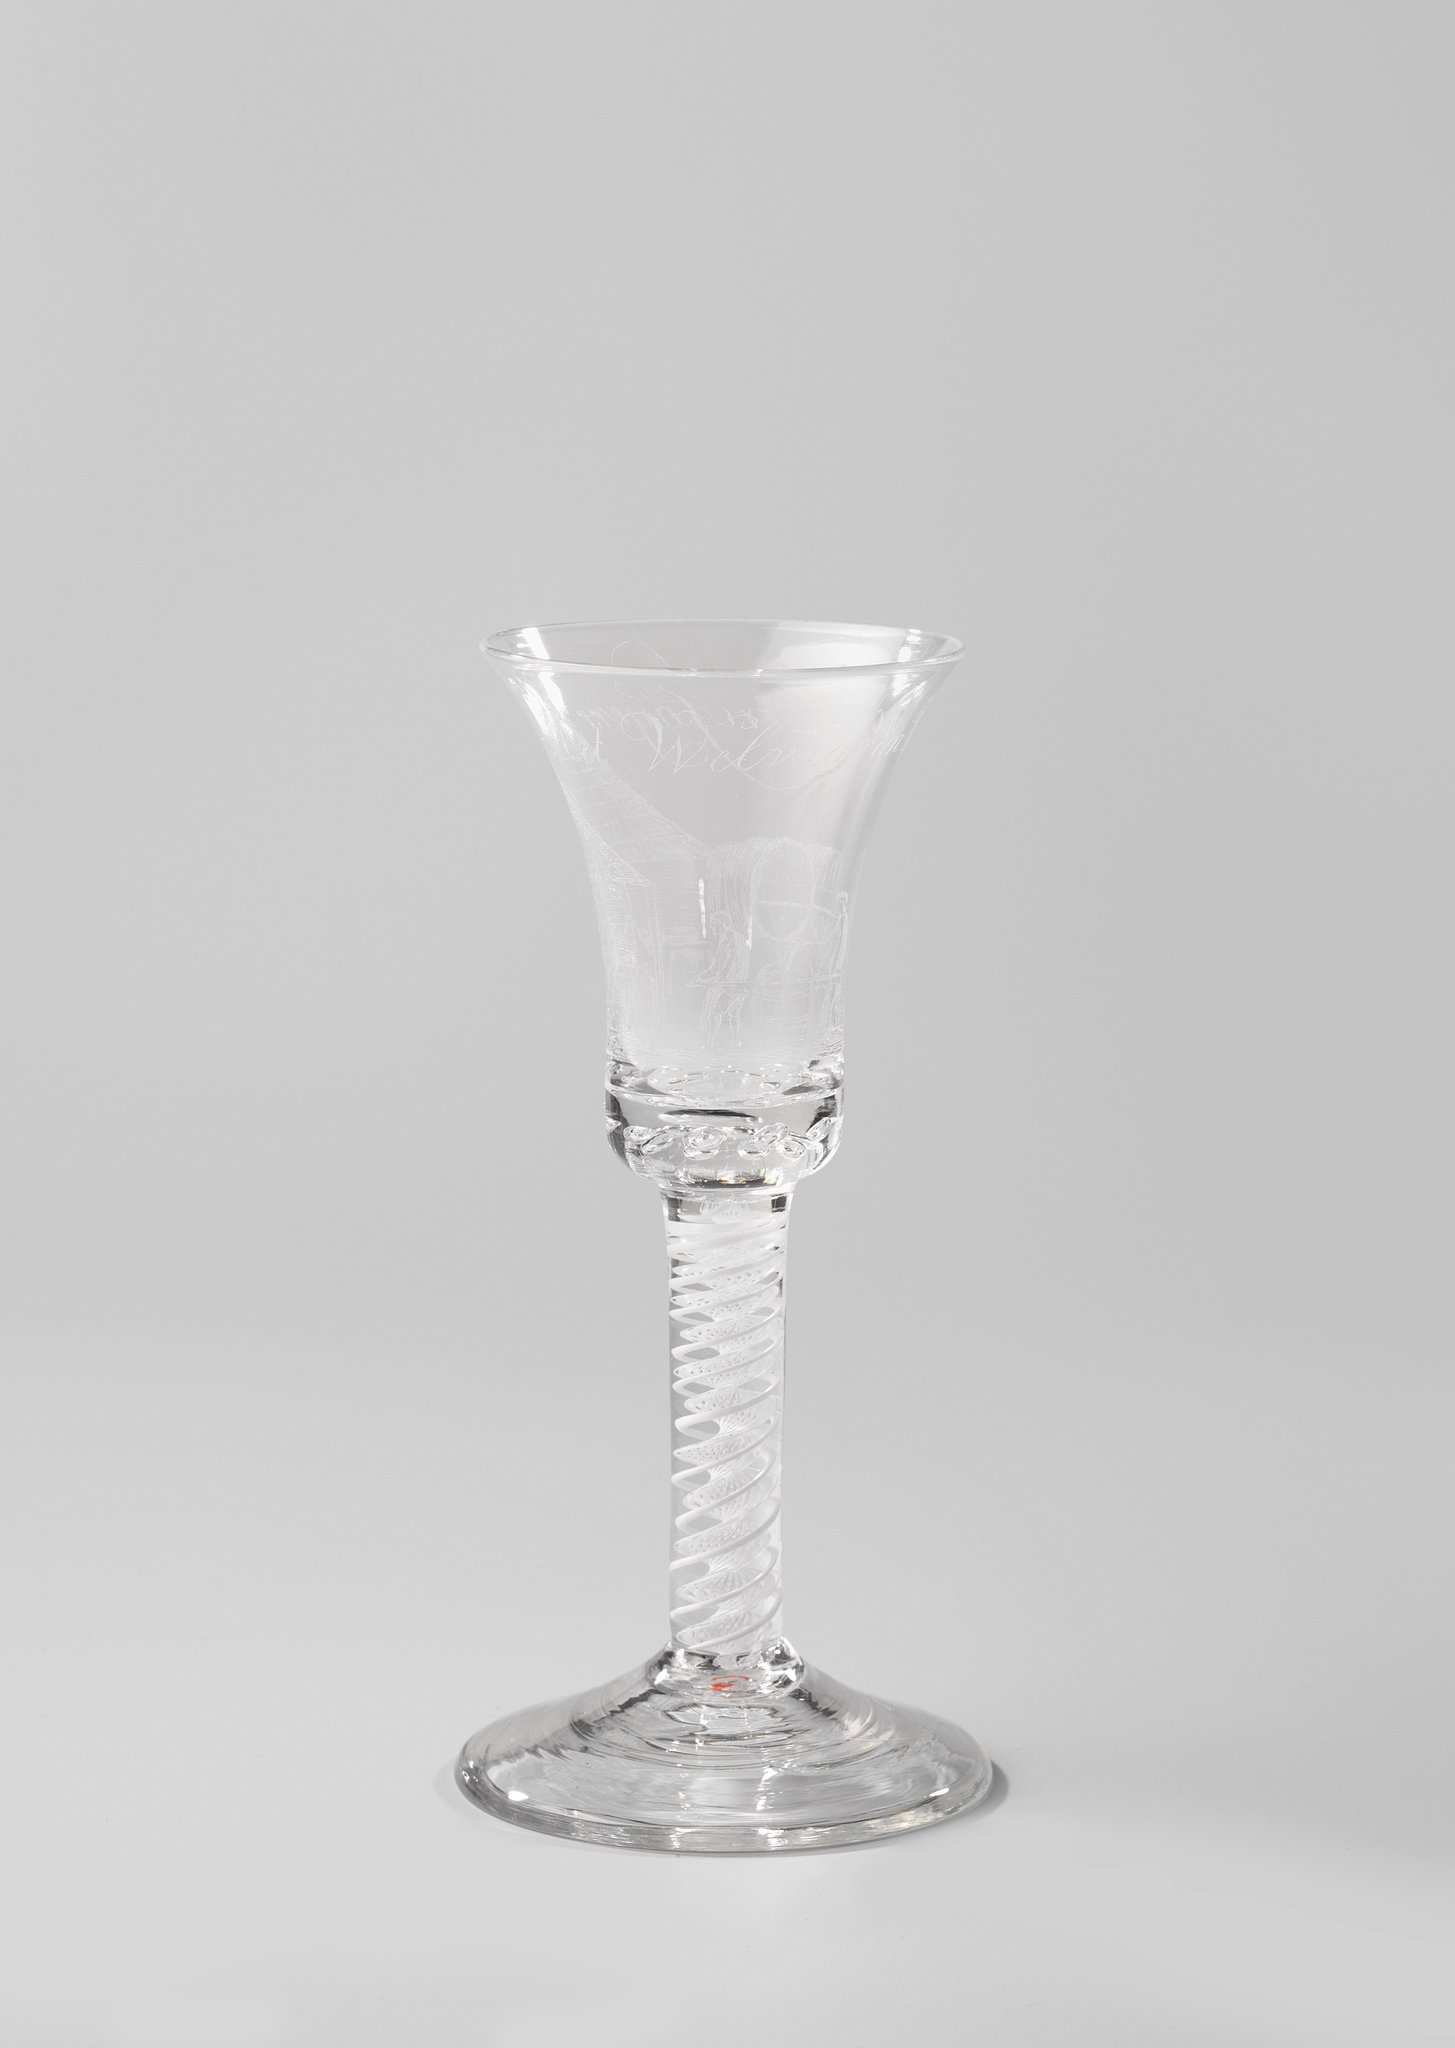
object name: goblet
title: Slingerglas met een stokerij en het opschrift: Het Welvaaren Van de Dri Saijers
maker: Anonymous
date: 1750-1775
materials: glass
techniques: diamond point engraving, glassblowing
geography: northern netherlands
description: Konische voet met pontilmerk. Rechte stam met dubbele witte slinger. Klokvormige kelk met dikke bodem, waarin een dubbele krans luchtbellen is gestoken. Op de kelk is een stokerij voorgesteld, waarvoor twee werklieden bezig zijn. Rechts dragen twee andere werklieden een ton. Links van de branderij een stapel tonnen. Boven de voorstelling het opschrift 'Het Welvaaren Van de Dri Saijers'.